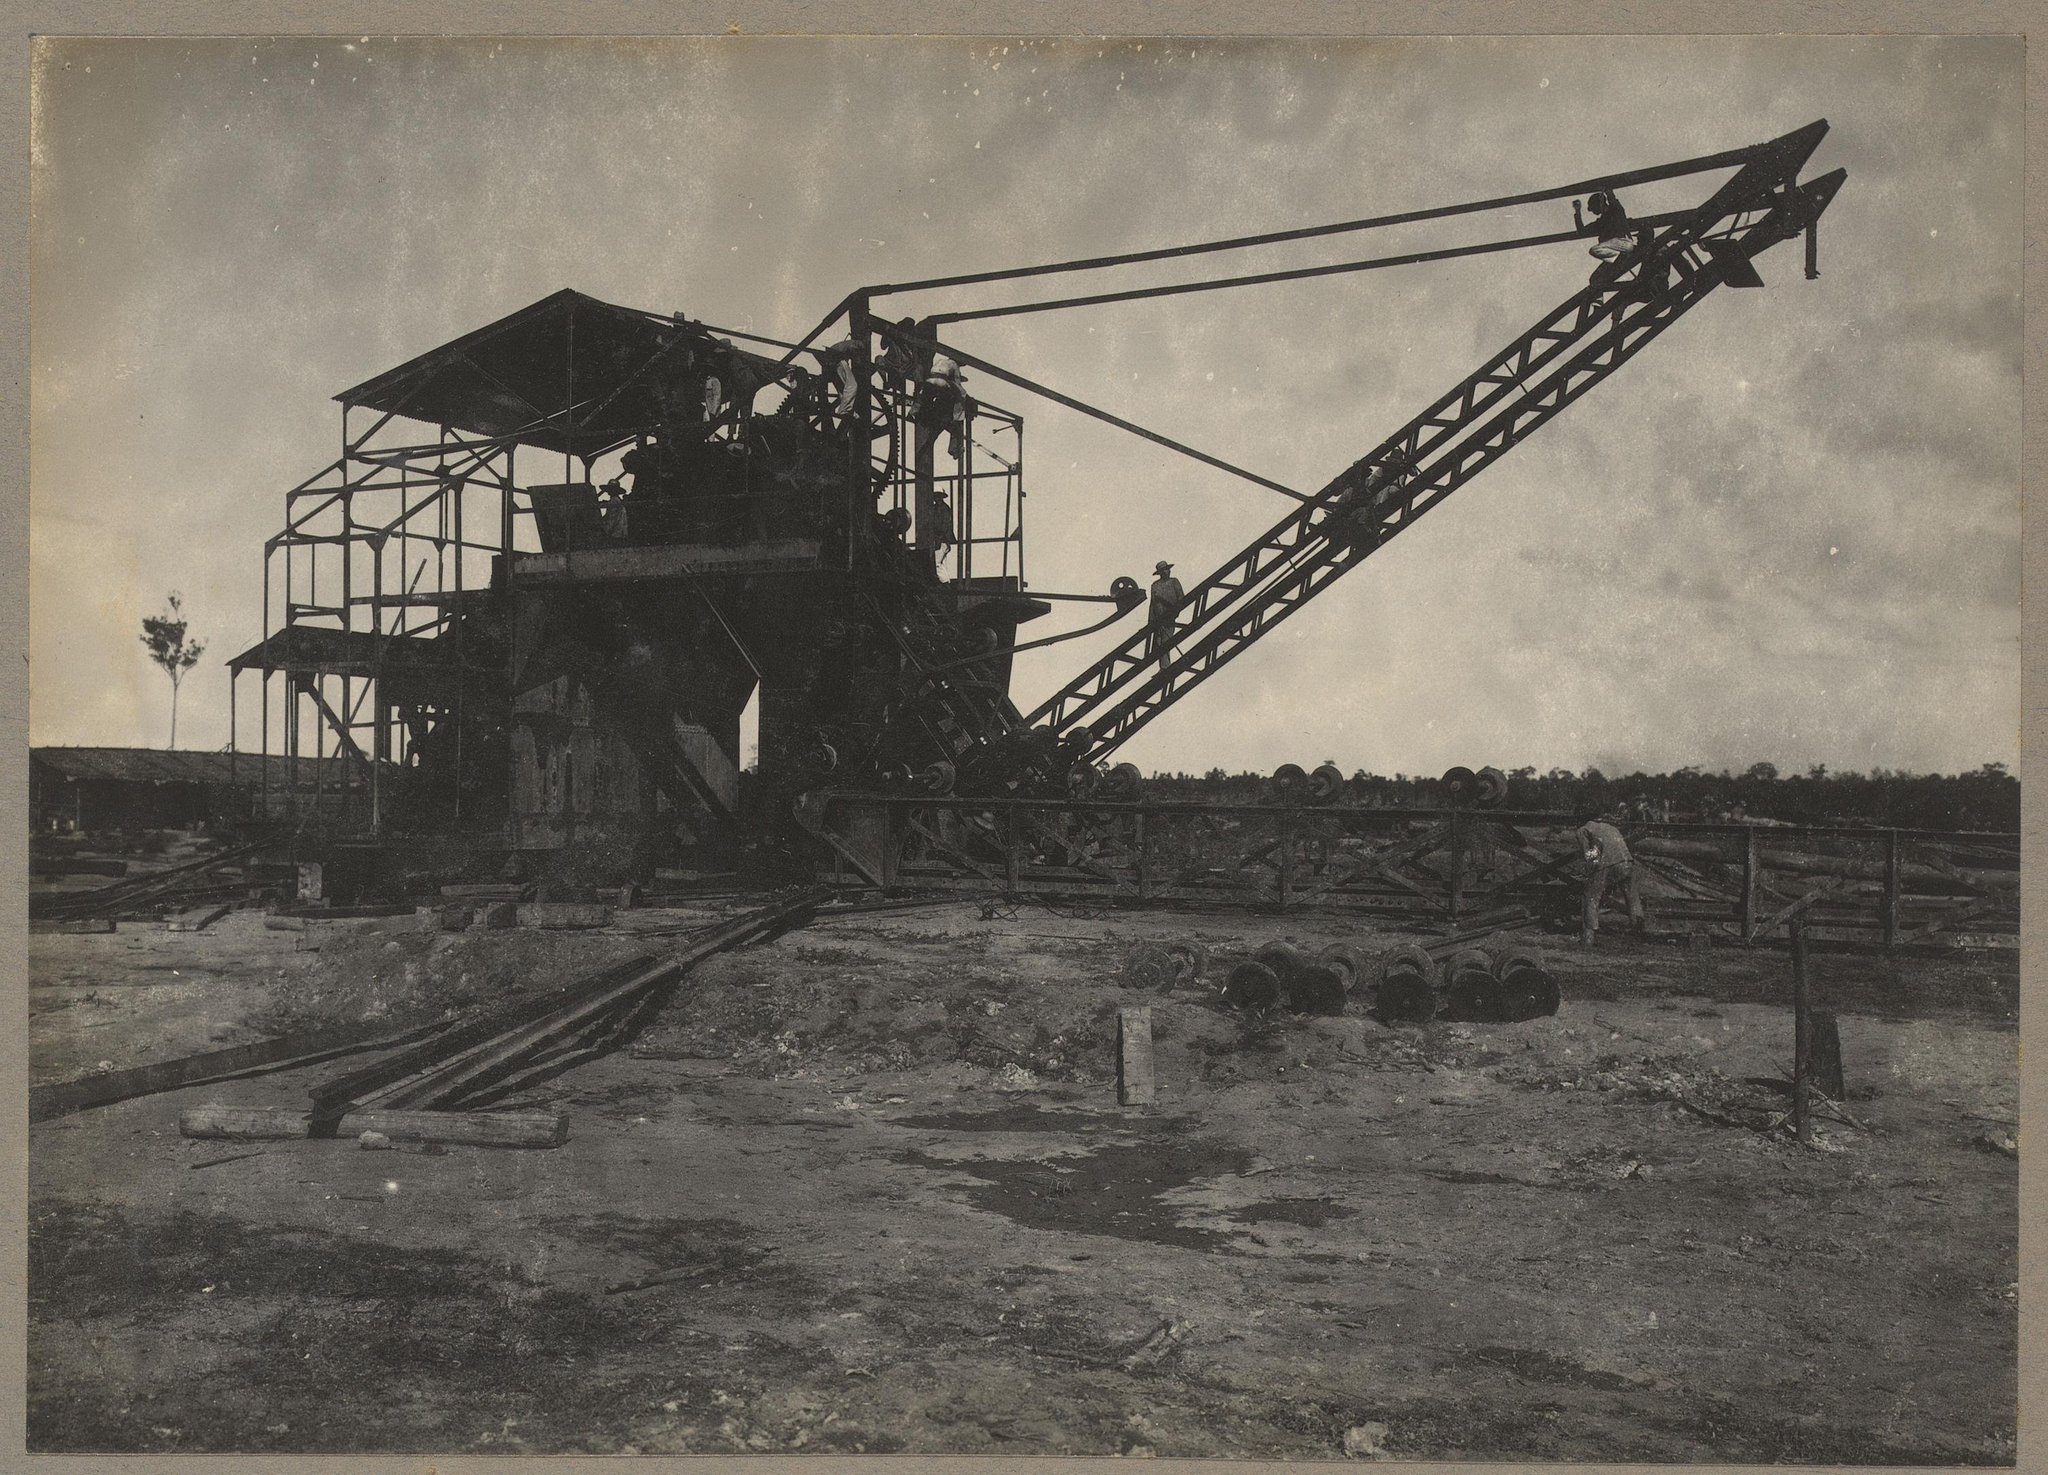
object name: photograph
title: Opstelling Excavateur mijn 3 Soengeiliat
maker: Anonymous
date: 1914-1919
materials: photographic support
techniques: gelatin silver print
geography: bangka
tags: robert julius boers, colonial system, opencast mine; strip mining, machines; parts of machines; tools and appliances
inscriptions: inscription: ‘Opstelling Excavateur mijn 3 Soengeiliat’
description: De excavateur in gereedheid gebracht in een open tinmijn (dagbouw) in Soengeiliat. Onderdeel van het fotoalbum aangeboden aan Robert Julius Boers bij zijn vertrek naar Nederland in 1919 door het personeel van de Banka-tinwinning.